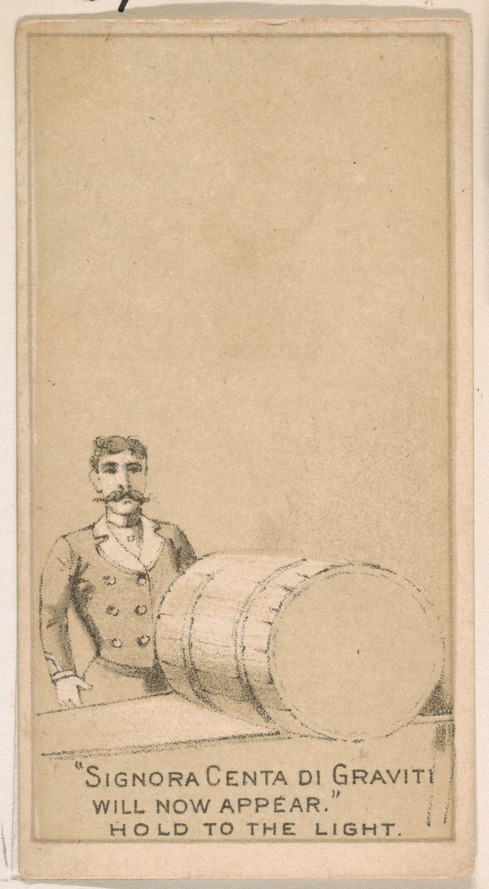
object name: print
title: Signora Centa di Graviti..., from the Magic Changing Cards series (N223) issued by Kinney Tobacco Company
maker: kinney brothers tobacco company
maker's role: publisher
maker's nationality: american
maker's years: 1869-2011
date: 1889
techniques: color lithograph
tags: men